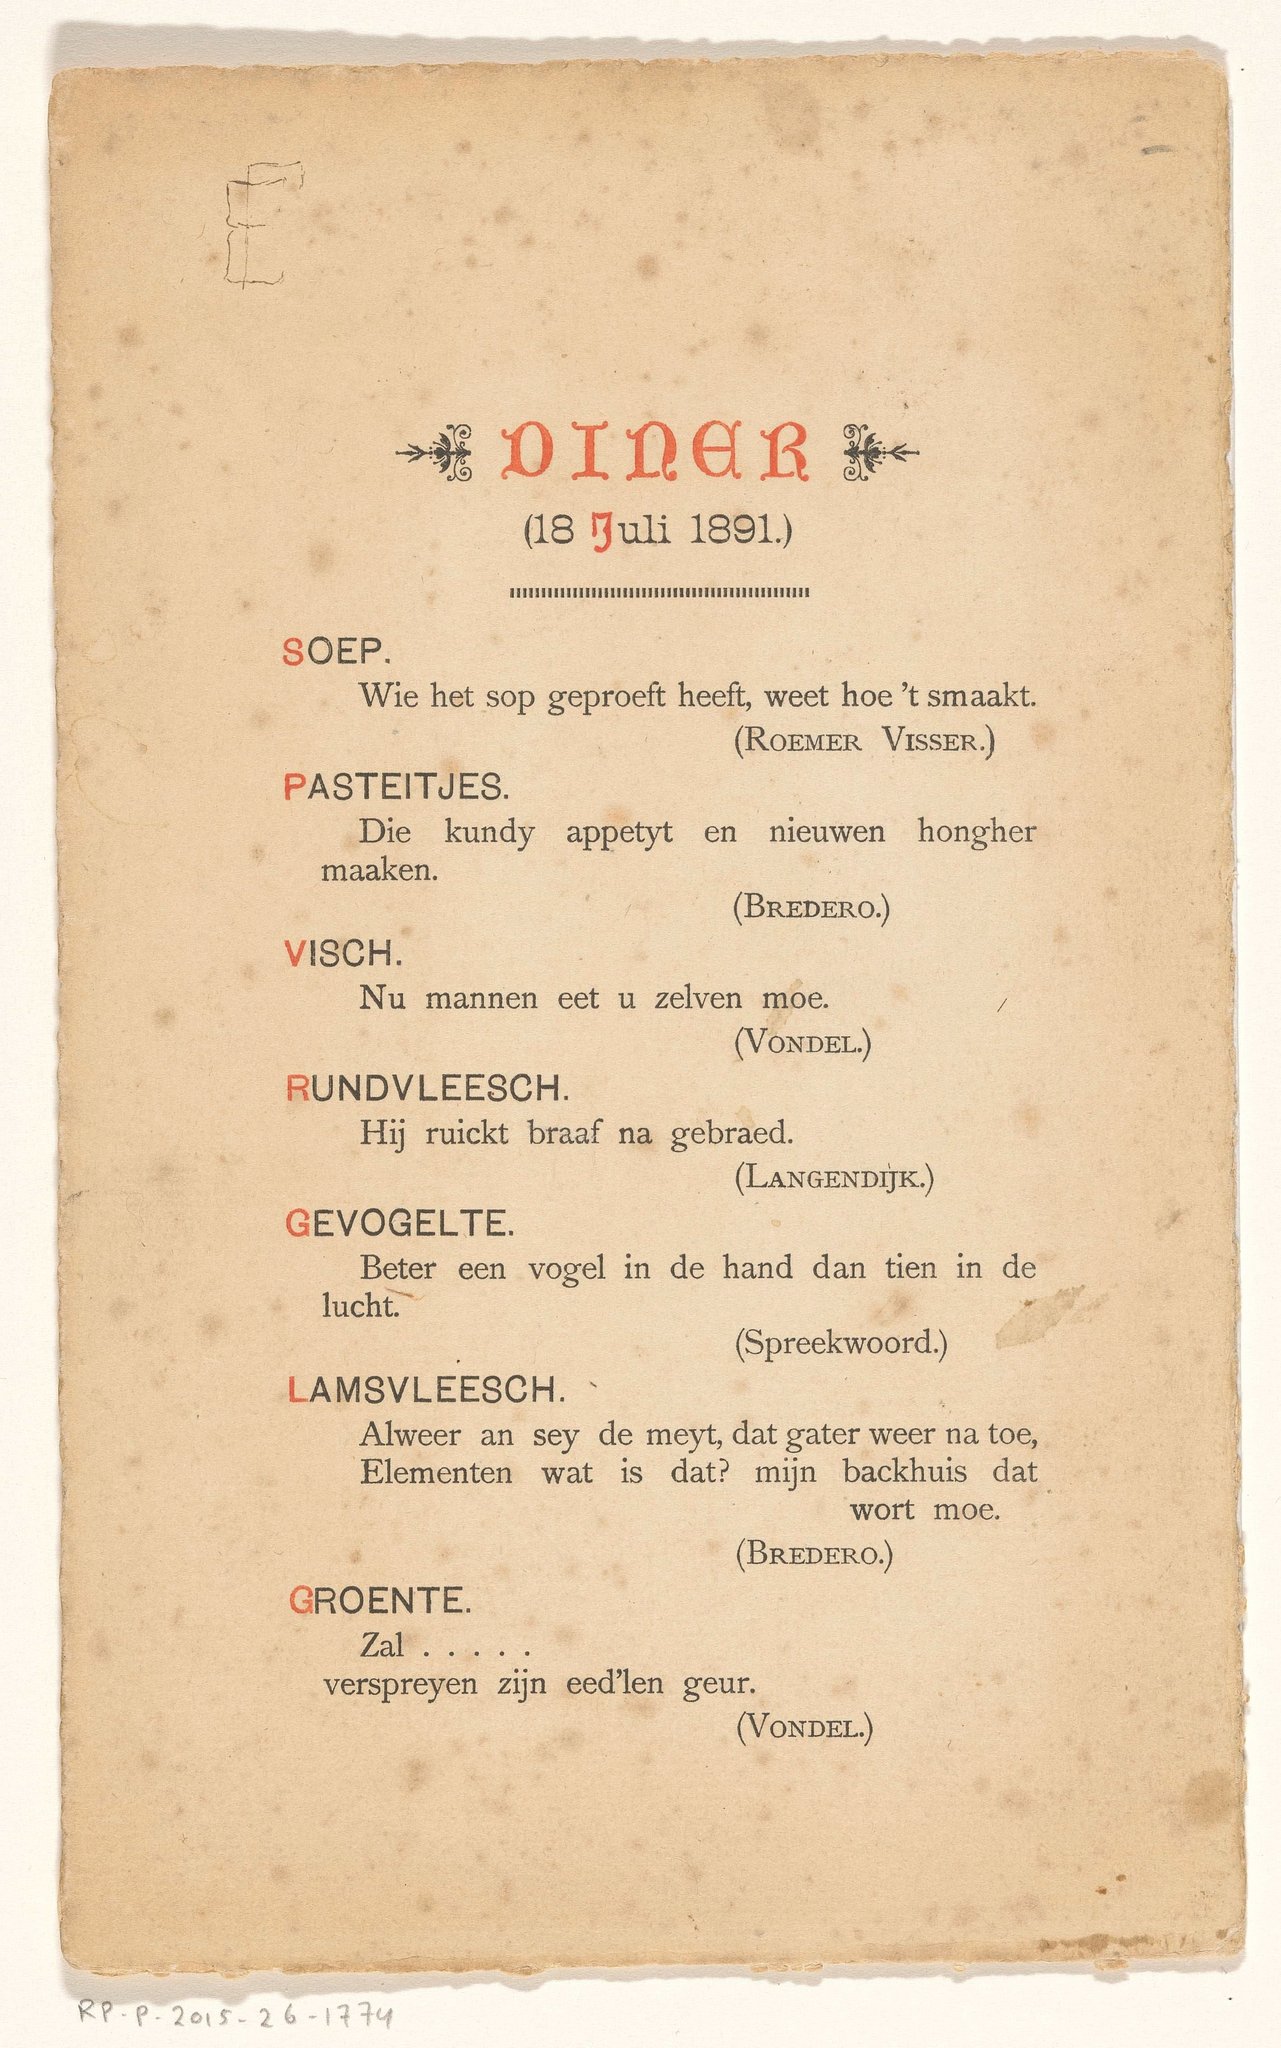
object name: print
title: Menukaart met citaten uit de Nederlandse literatuur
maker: Anonymous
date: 1891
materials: cardboard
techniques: letterpress printing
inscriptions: collector's mark: Lugt 2228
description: Menukaart voor een diner dat plaatsvond op 18 juli 1891. De verschillende gangen zijn voorzien van toepasselijke citaten afkomstig uit de Nederlandse literatuur.